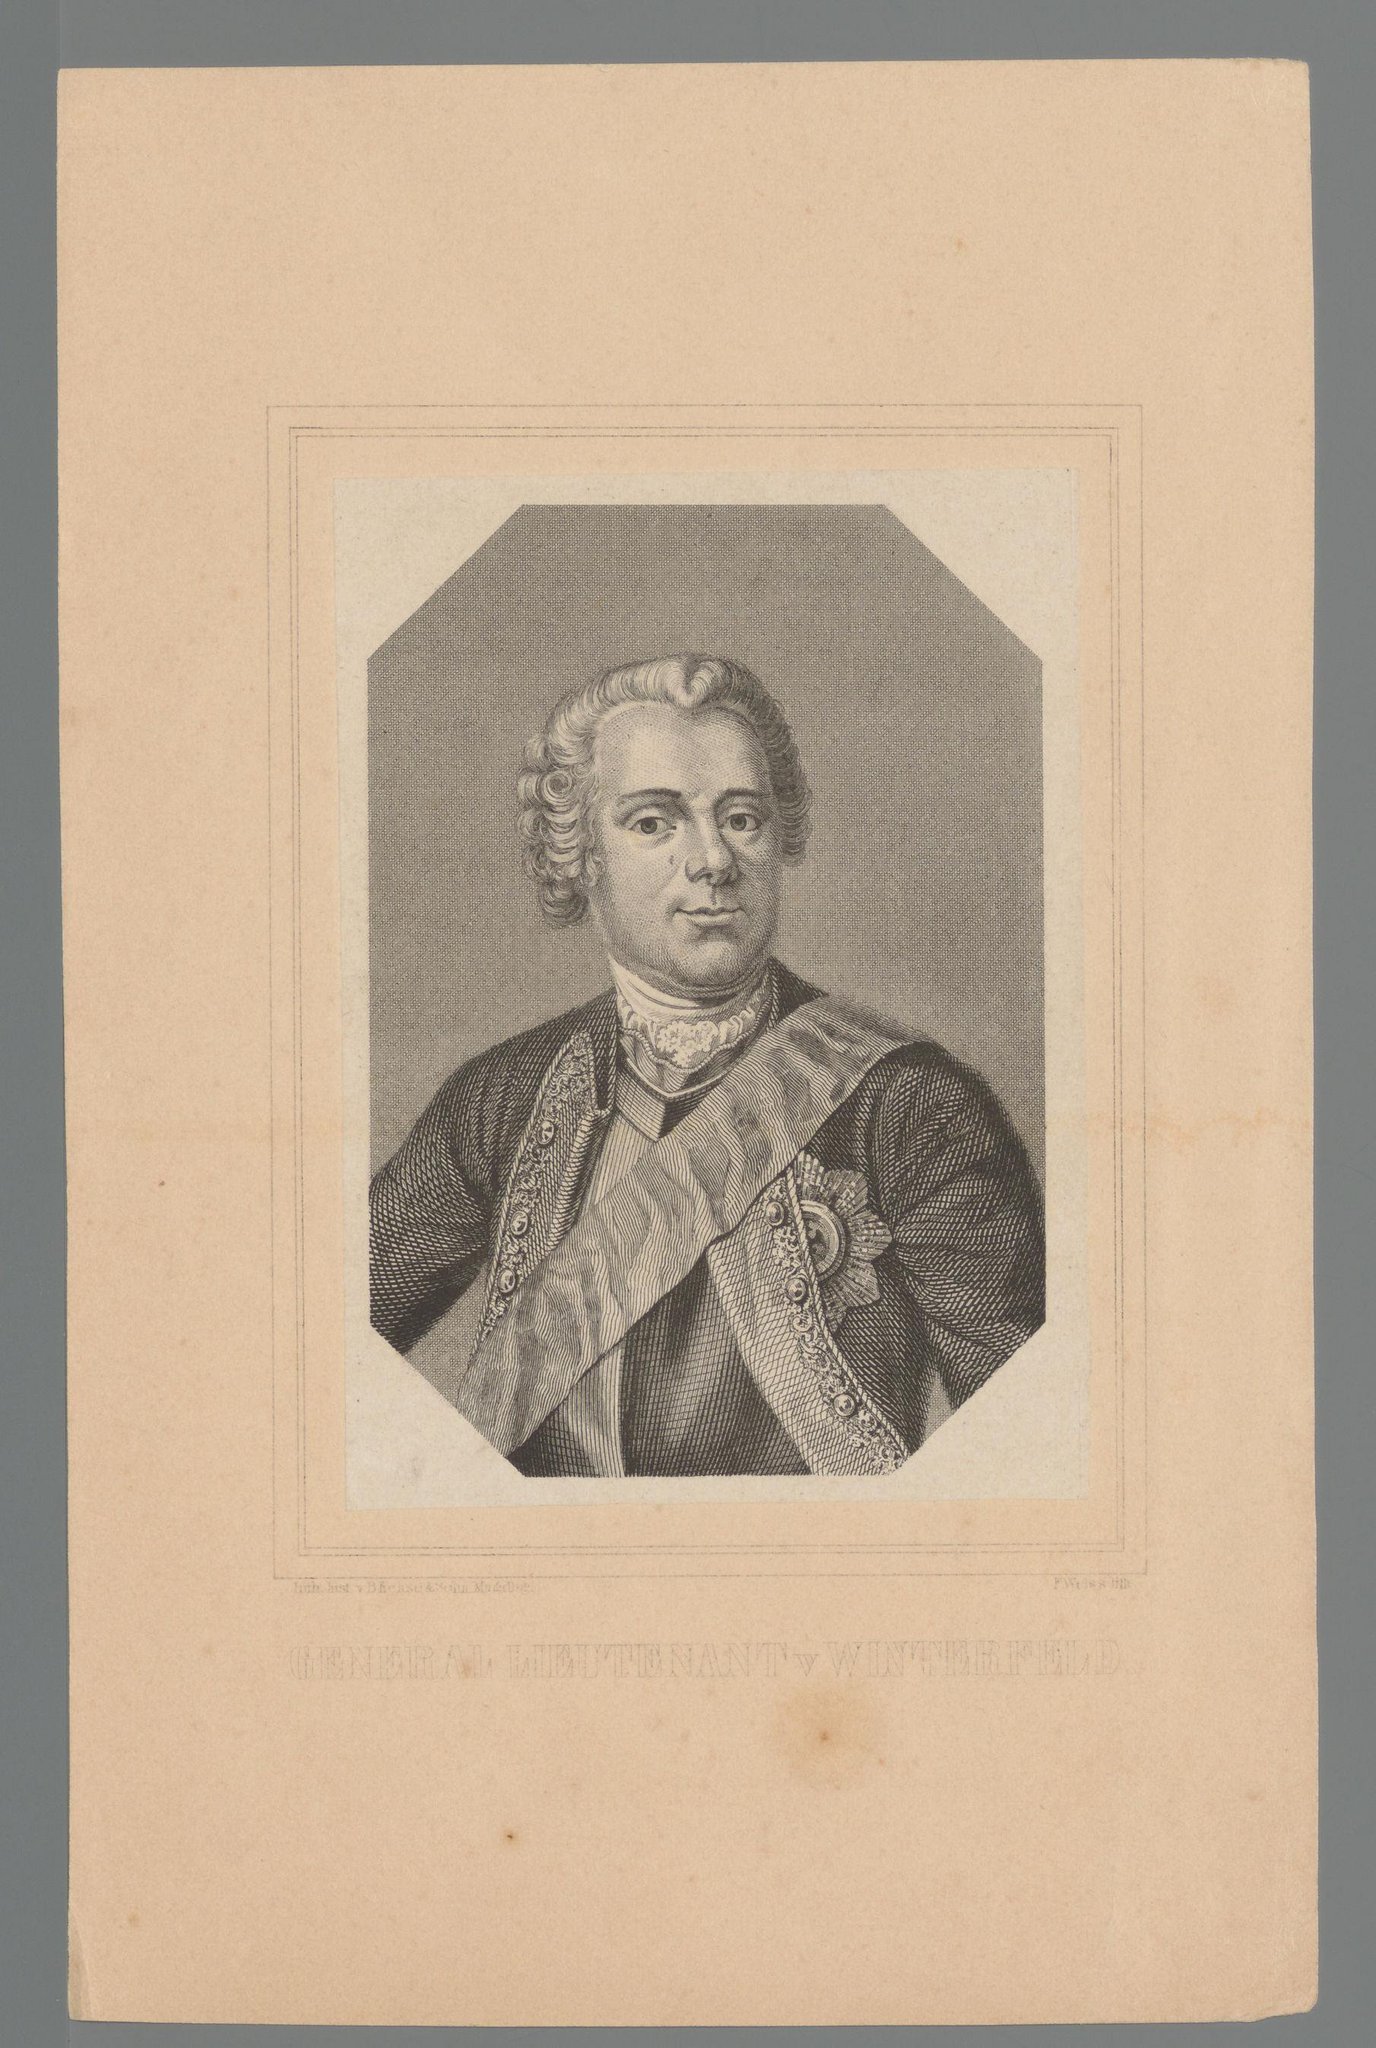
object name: print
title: Portret van Hans Carl von Winterfeldt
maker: ferdinand weiss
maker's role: print maker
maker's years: 1814-1878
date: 1830-1840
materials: paper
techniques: lithograph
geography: magdeburg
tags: adult man, historical persons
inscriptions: collector's mark: Lugt 2228